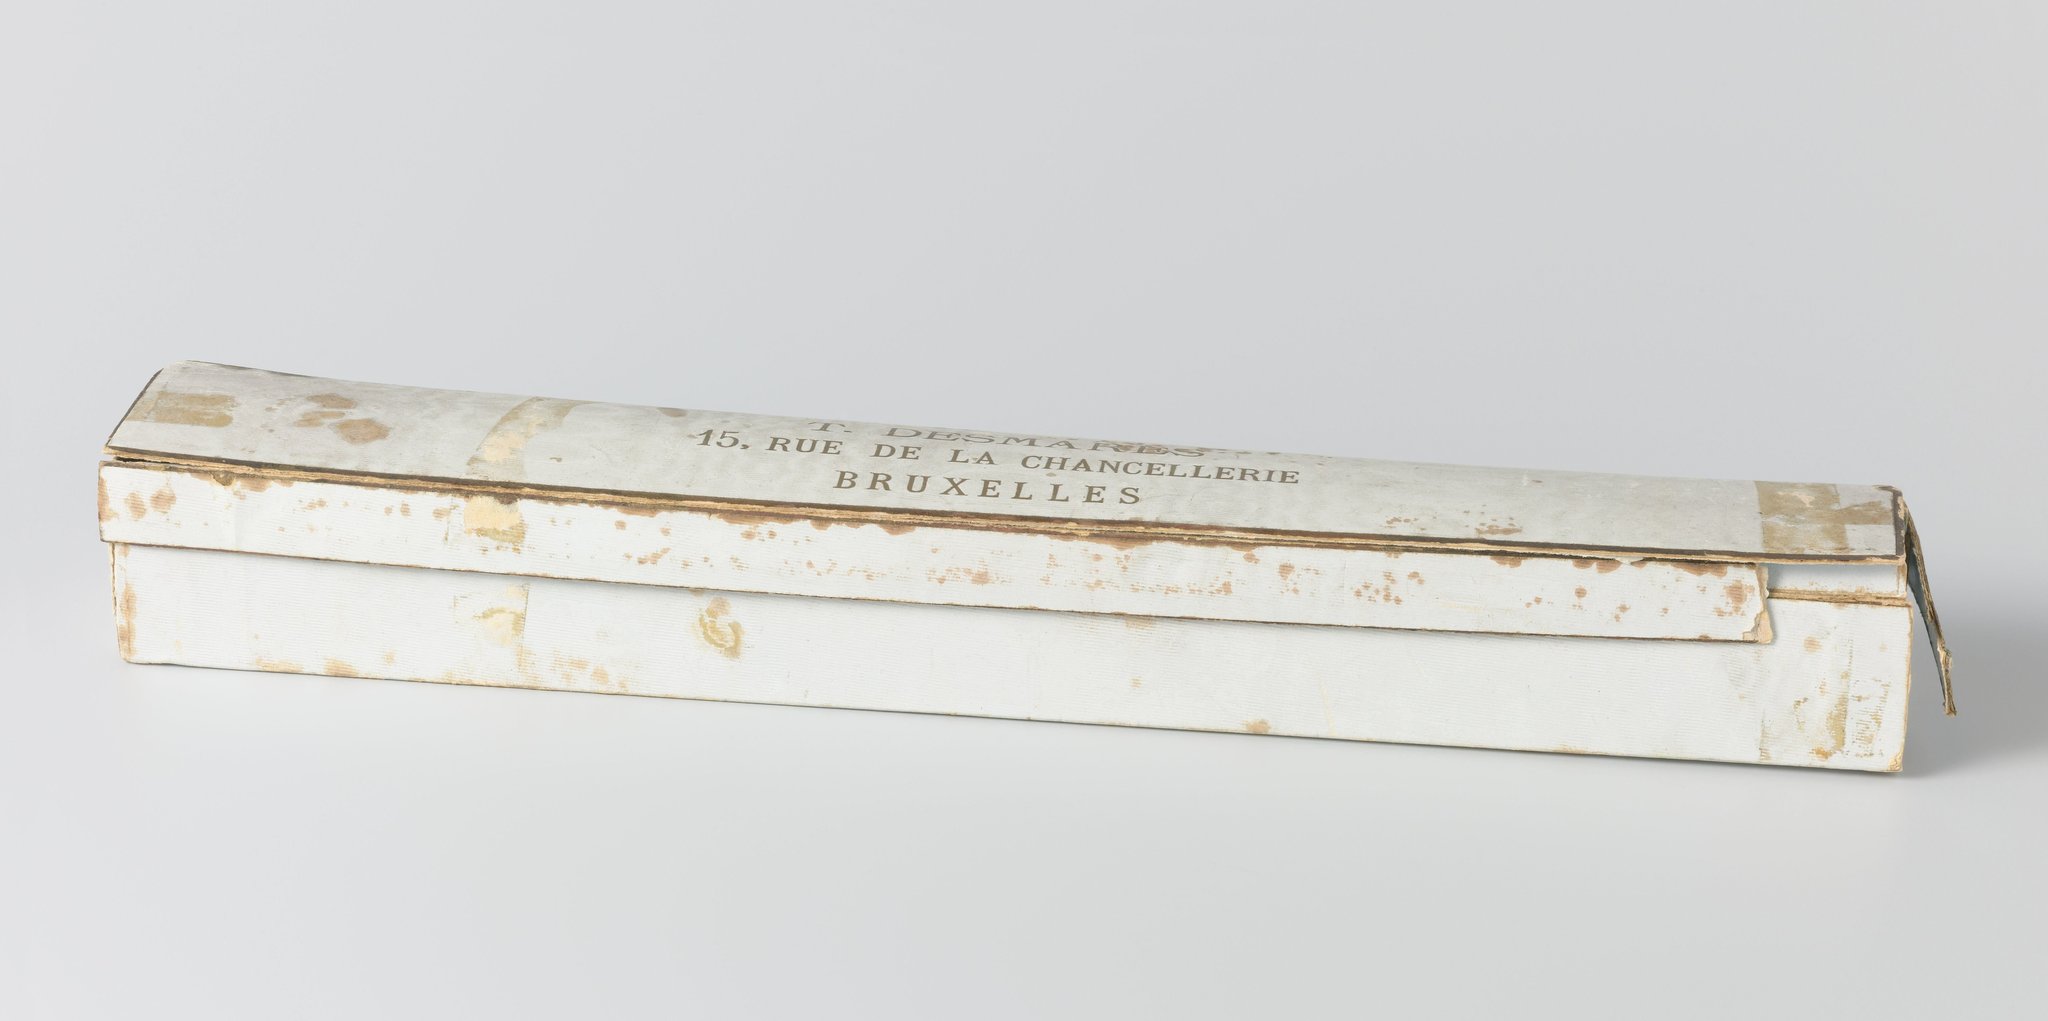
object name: packing material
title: Waaierdoos van papier met losse deksel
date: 1875-1900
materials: paint, paper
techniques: pasting, scooping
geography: brussels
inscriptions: company name: ‘T. DESMARÈS/15 RUE DE LA CHANCELLERIE/BRUXELLES’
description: Waaierdoos van papier, de buitenkant is beplakt met zachtgrijs gewaterd papier, waarbij de randen zijn afgezet met goudpapier. De binnenzijde is beplakt met blauw papier. De deksel is los en heeft een opdruk met de firmanaam en adres in goudkleurige letters.